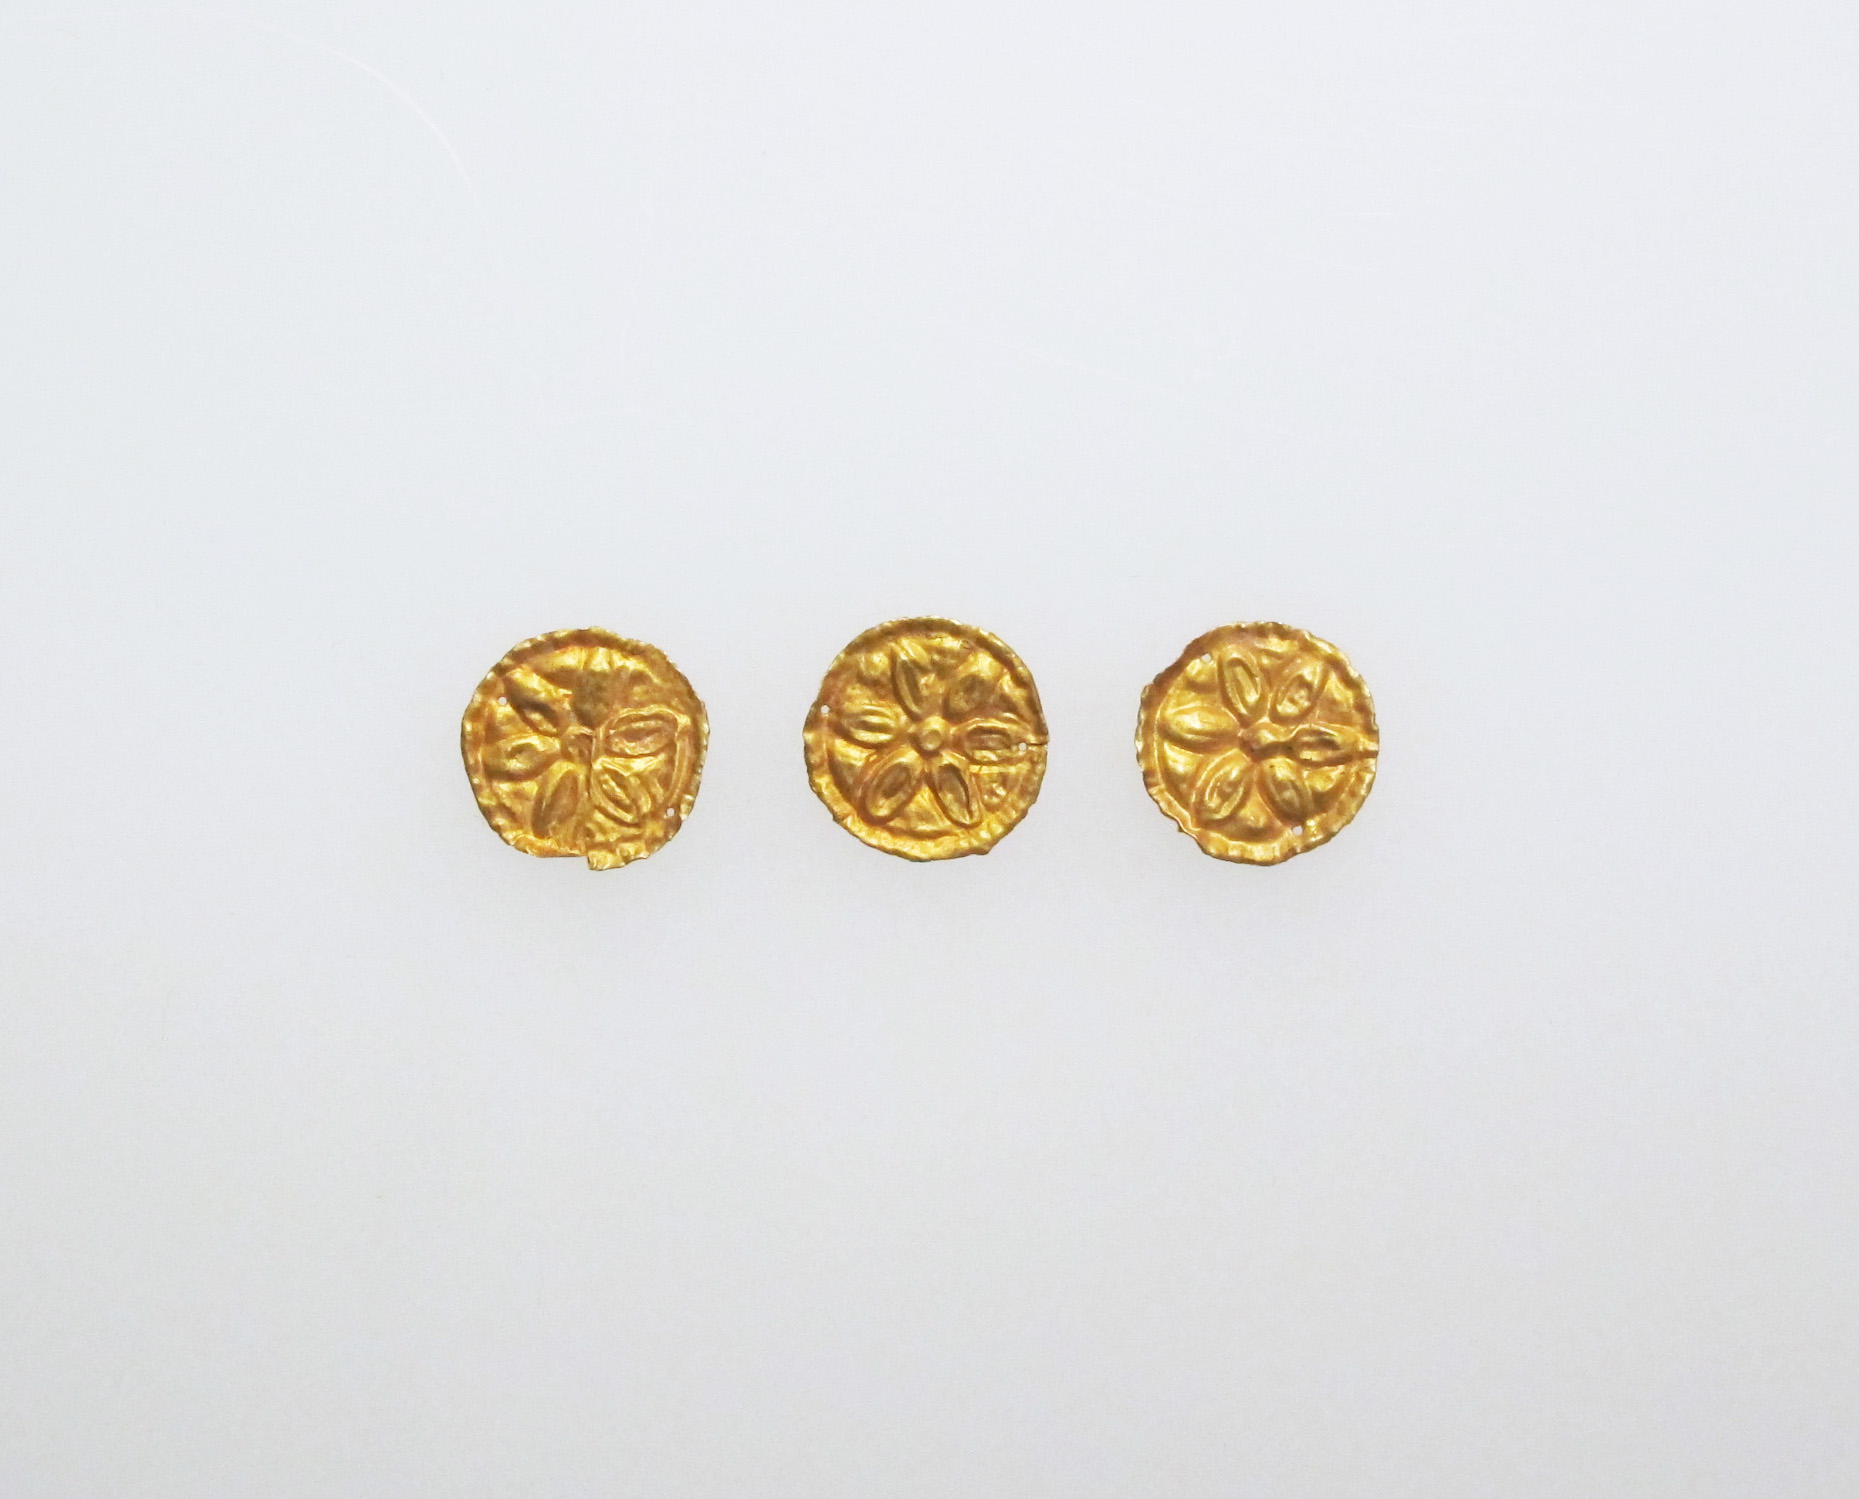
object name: bead ornament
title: Bead ornaments, 3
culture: roman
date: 201-300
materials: gold